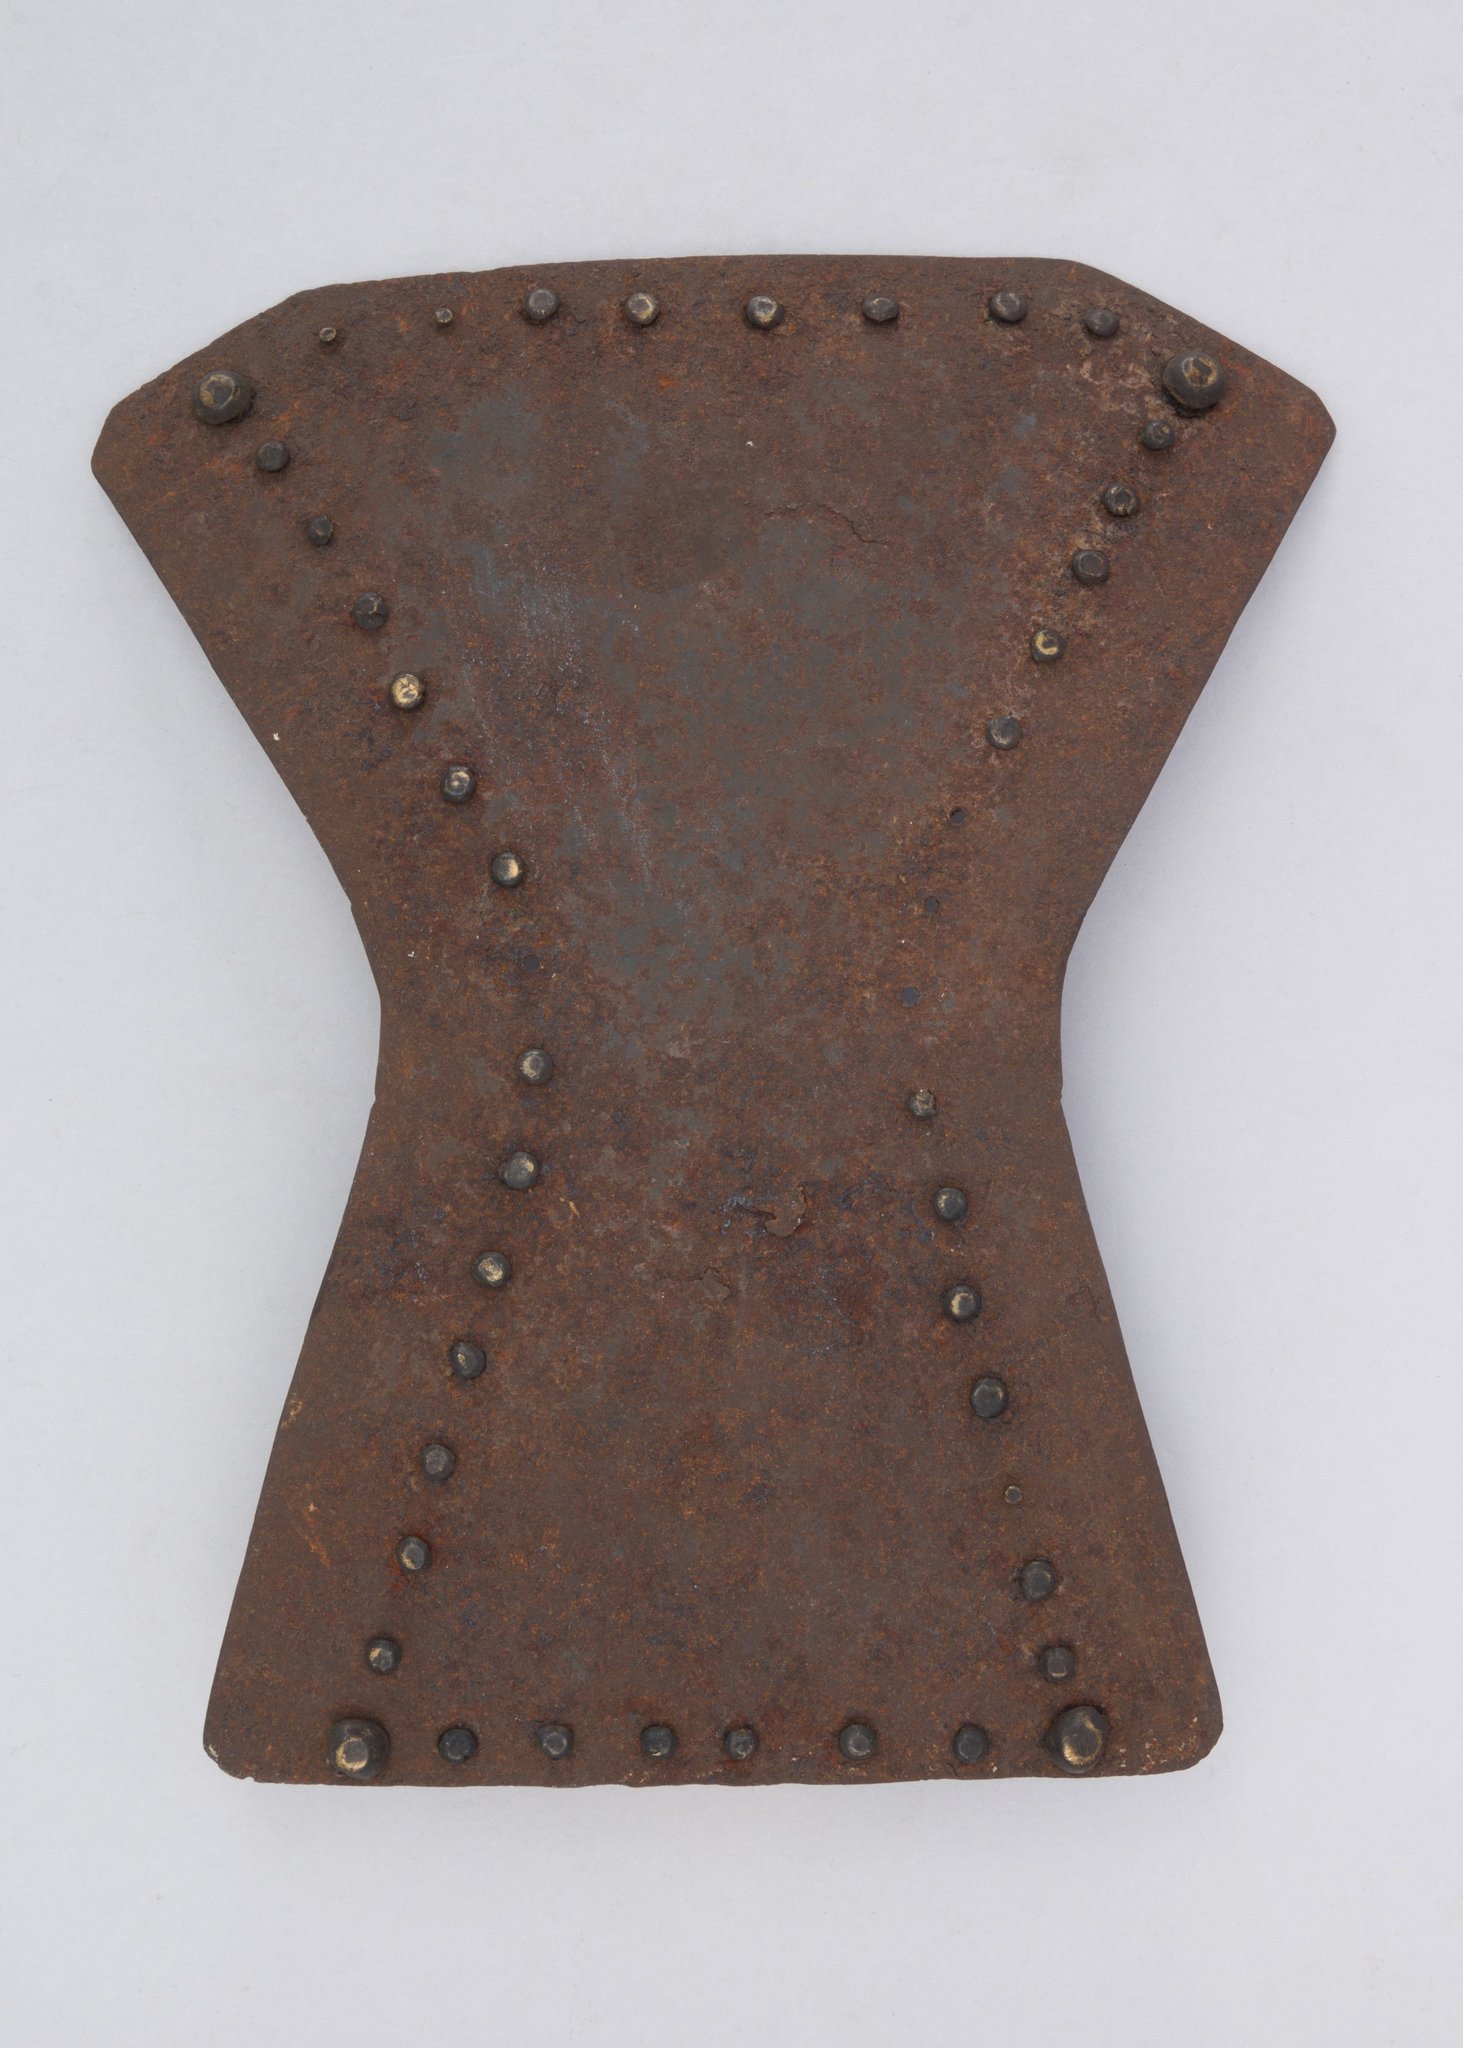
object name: brigandine plate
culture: italian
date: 1400-1450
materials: copper alloy, metal alloy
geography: italy